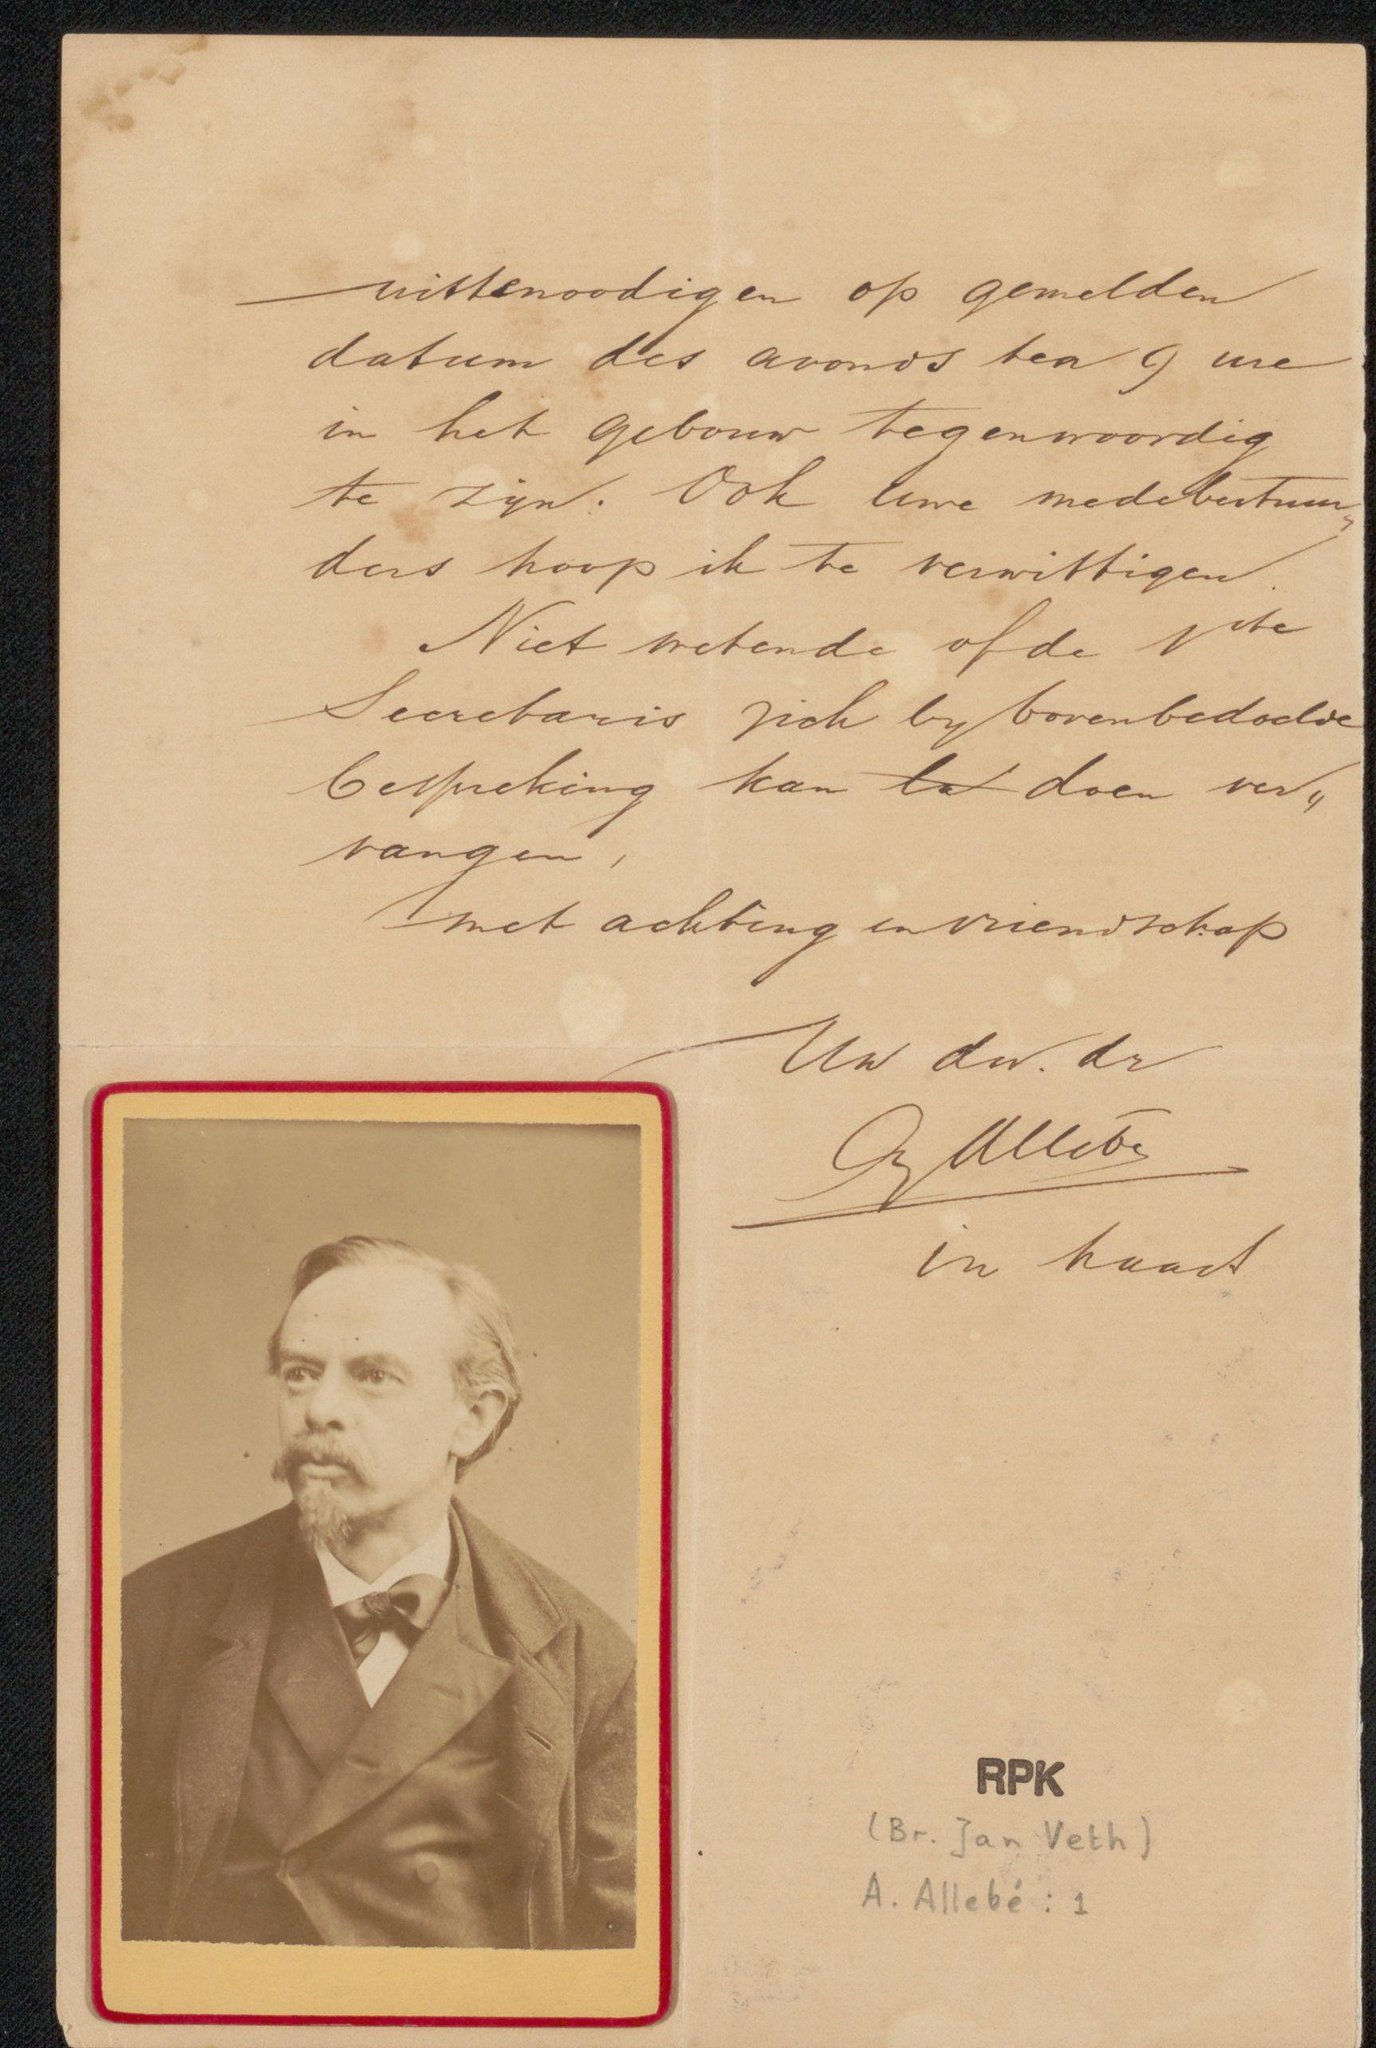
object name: letter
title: Brief aan Jan Veth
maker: august allebé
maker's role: draughtsman, print maker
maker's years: 1838-1927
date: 1883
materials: ink, paper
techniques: pen, printing, writing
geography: amsterdam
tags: dordrecht, painter, print maker, draughtsman, designer, jan veth, politician, jérôme alexander sillem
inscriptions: collector's mark: ‘RPK’